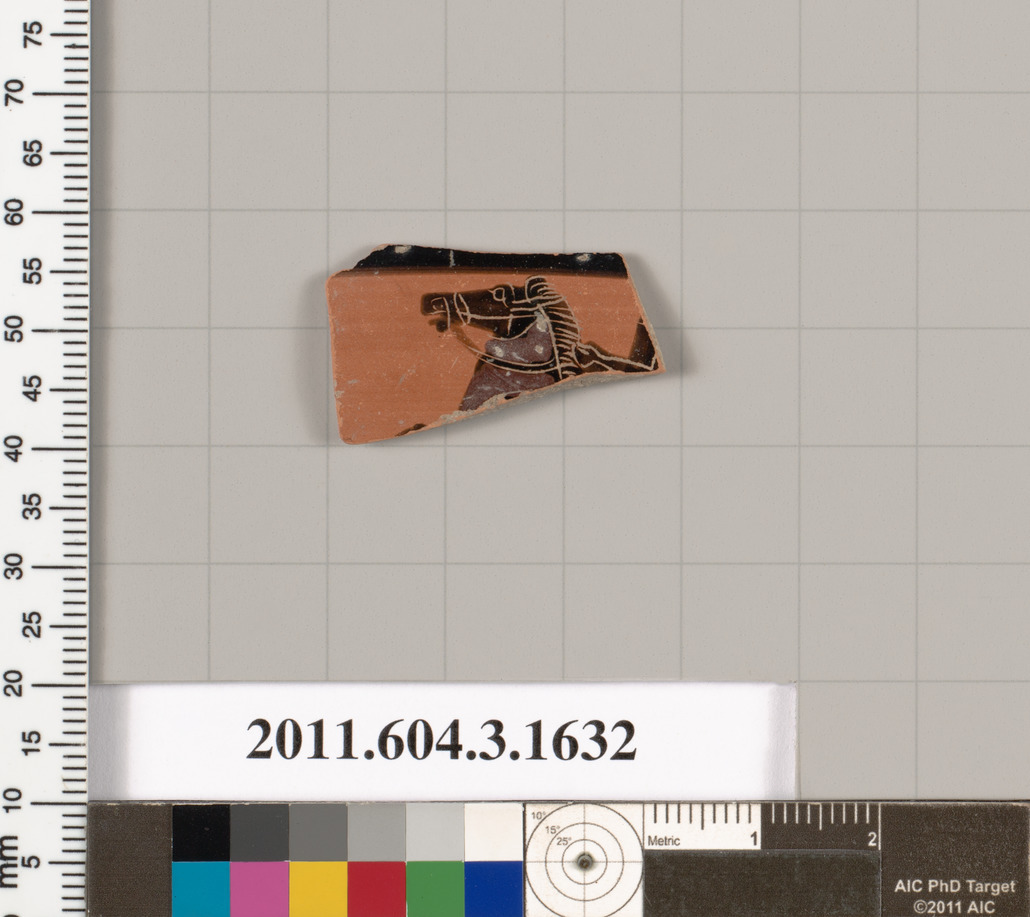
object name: kylix fragment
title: Terracotta fragment of a kylix: Band cup (drinking cup)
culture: greek, attic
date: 567-535 BCE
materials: terracotta